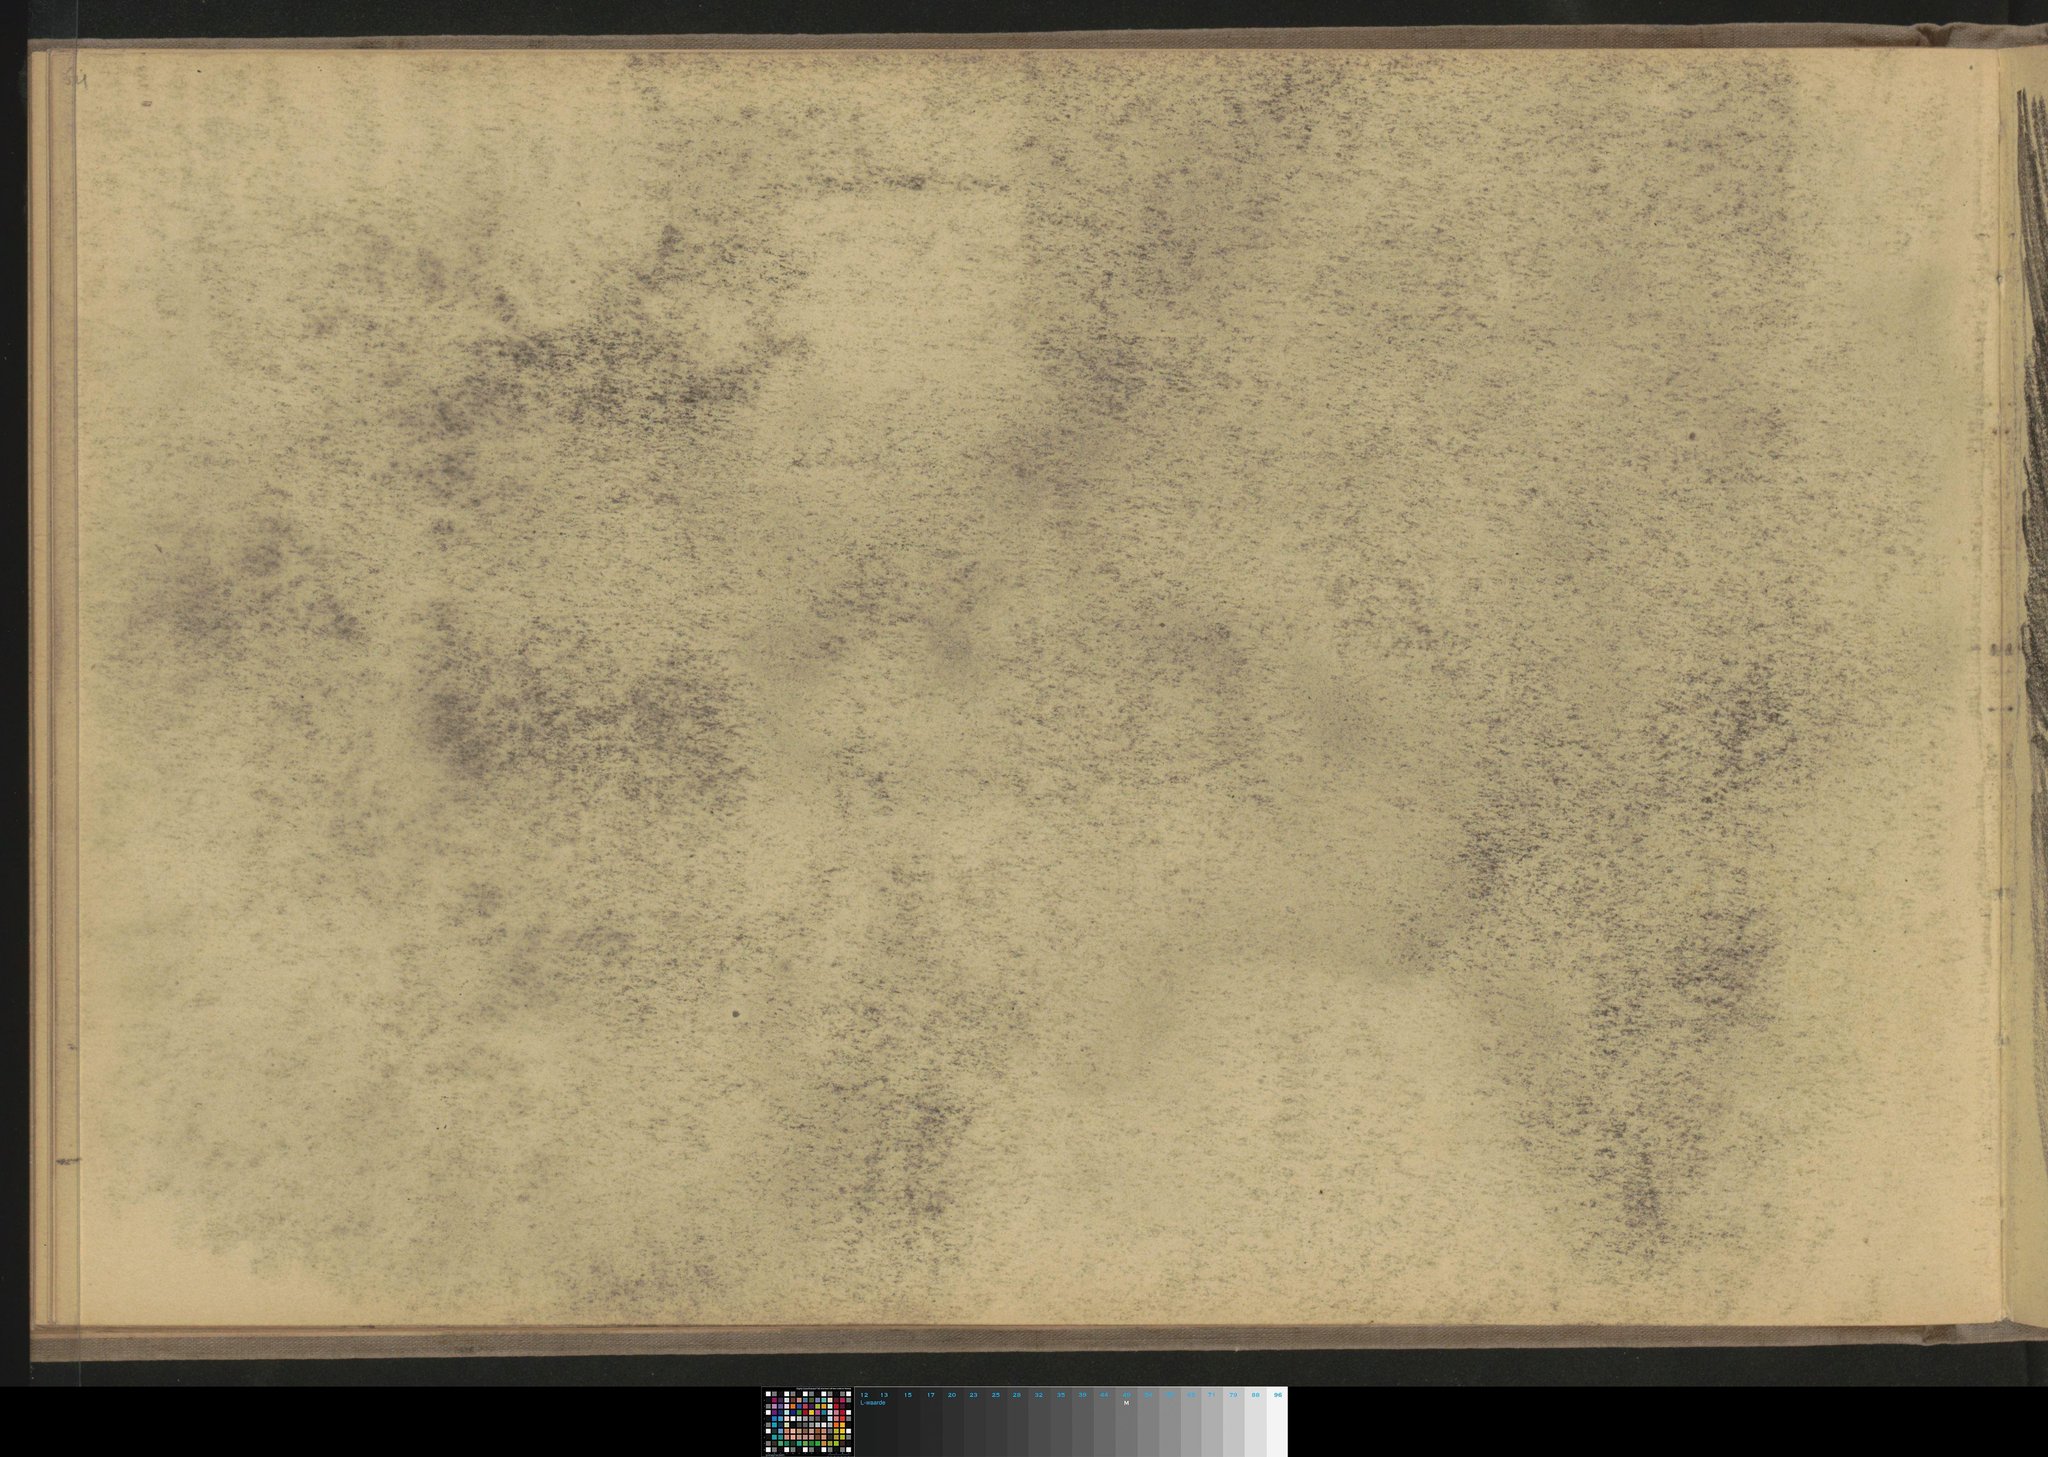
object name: sketchbook leaf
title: Abklatsch van de krijttekening op pagina 55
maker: willem witsen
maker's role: draughtsman, painter, print maker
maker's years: 1860-1923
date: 1901-1907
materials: paper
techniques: printmaking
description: Pagina 54 uit een schetsboek met 60 bladen.